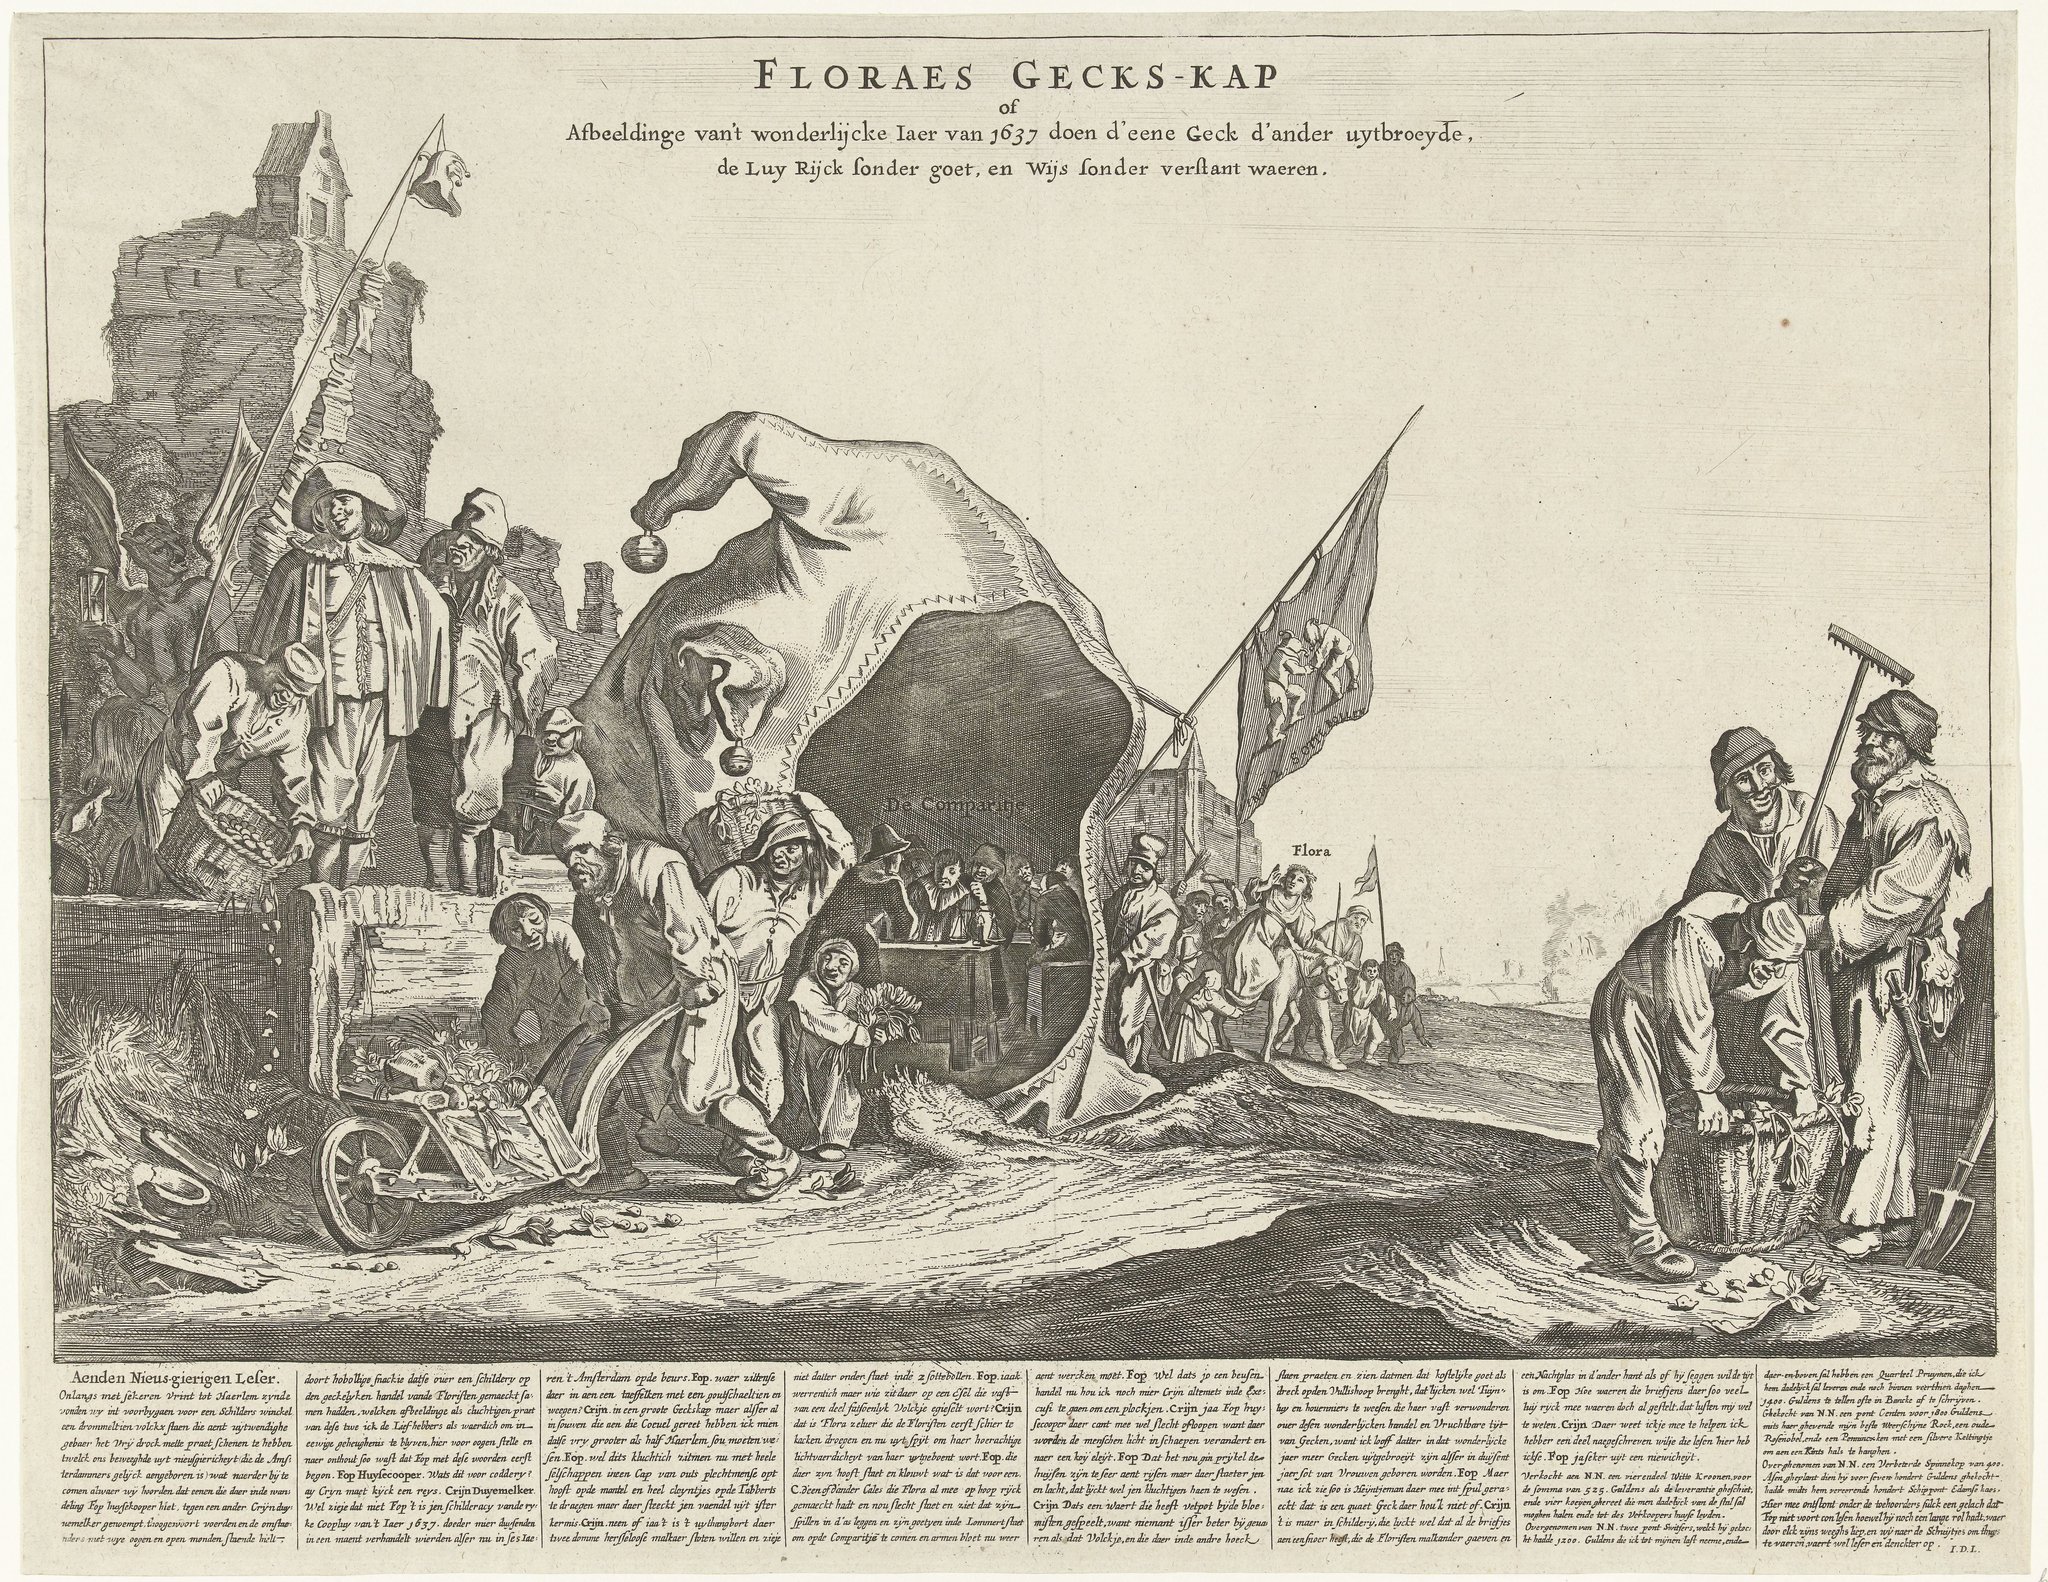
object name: cartoon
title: Floraes Gecks-kap, 1637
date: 1637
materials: paper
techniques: engraving, etching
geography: northern netherlands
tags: speculative boom, negative results and undesired aspects of trading, (story of) flora - suffering, misfortune, fool's cap, flowers: tulip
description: Floraes Gecks-kap. Spotprent op de tulpenmanie, windhandel in tulpenbollen in het jaar 1637. In een herberg in de vorm van een grote narrenkap zitten tulpenhandelaren. Links op een verhoging staat de duivel met een zandloper, handelaren met een stok met inschrijvingen en een boer die een mand met bollen op de mesthoop omkeert. Daarvoor en rechtsvooraan verschillende bollenboeren. Op de achtergrond wordt Flora gezeten op een ezel weggejaagd. Onder de voorstelling een lange tekst in 8 kolommen in het Nederlands.